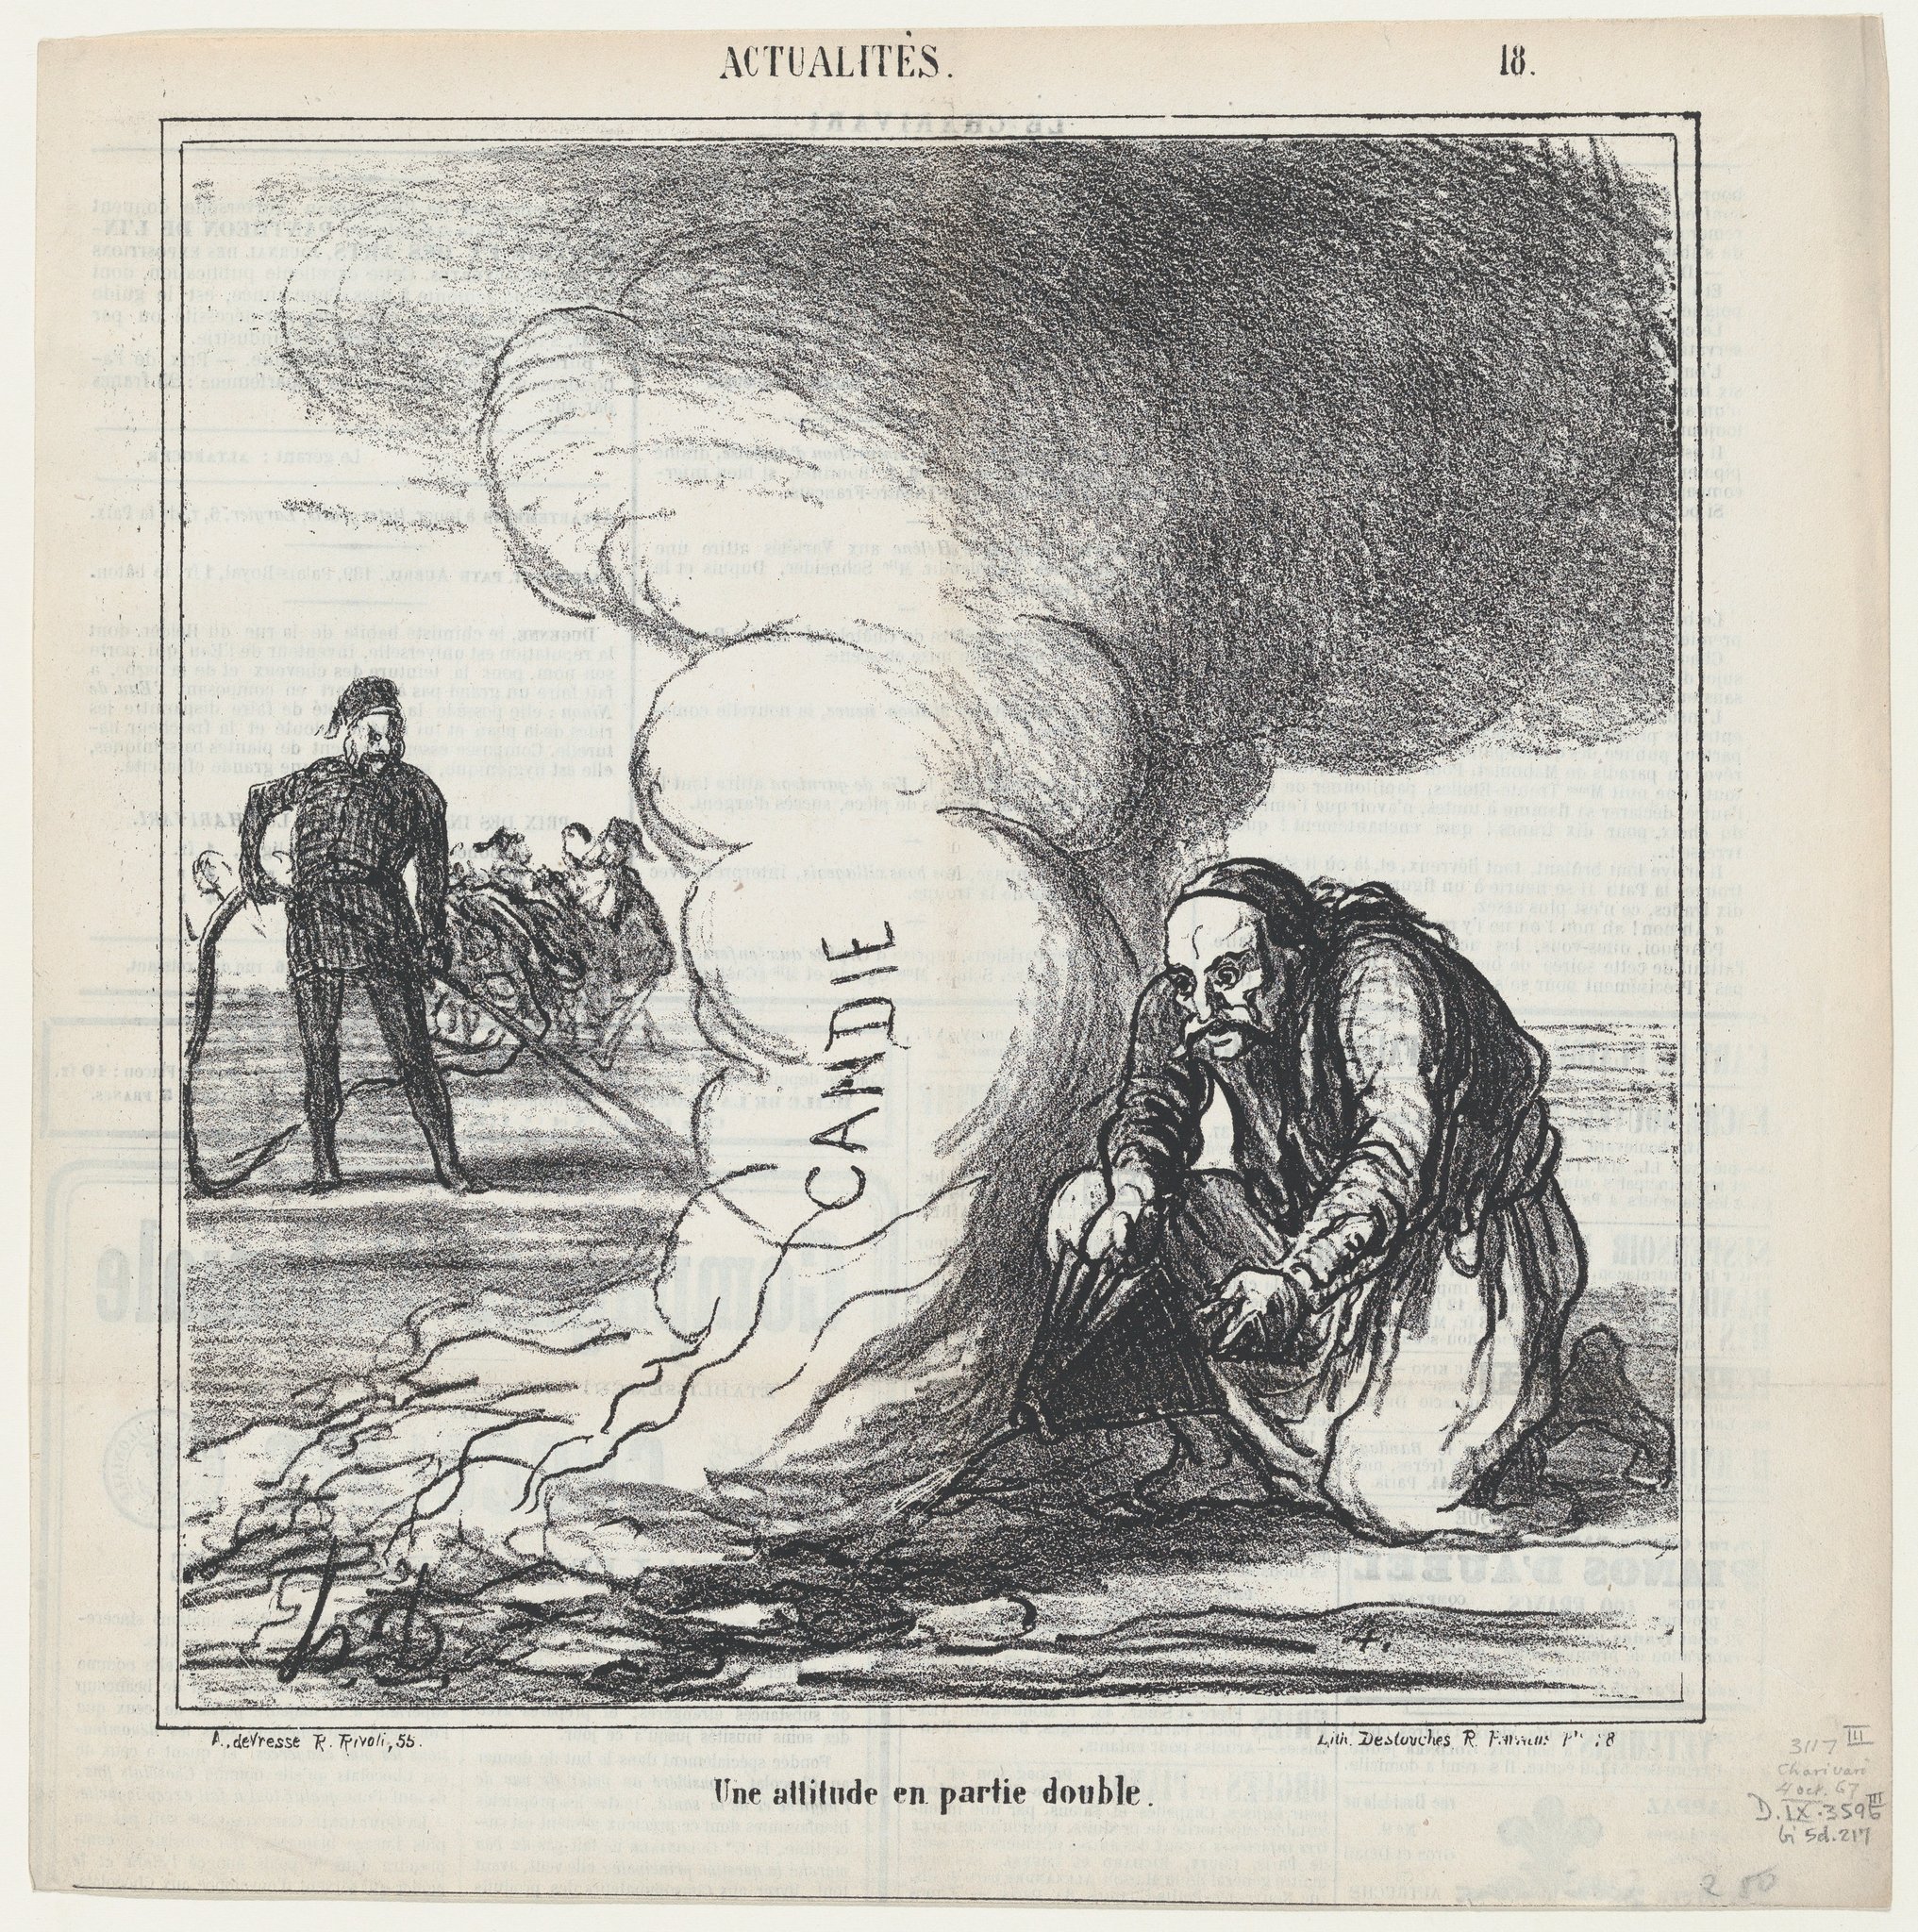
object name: print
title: A treacherous attitude, from 'News of the day,' published in Le Charivari, October 4, 1867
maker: honoré daumier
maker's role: artist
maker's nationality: french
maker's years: 1808-1879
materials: paper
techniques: lithograph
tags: men,working